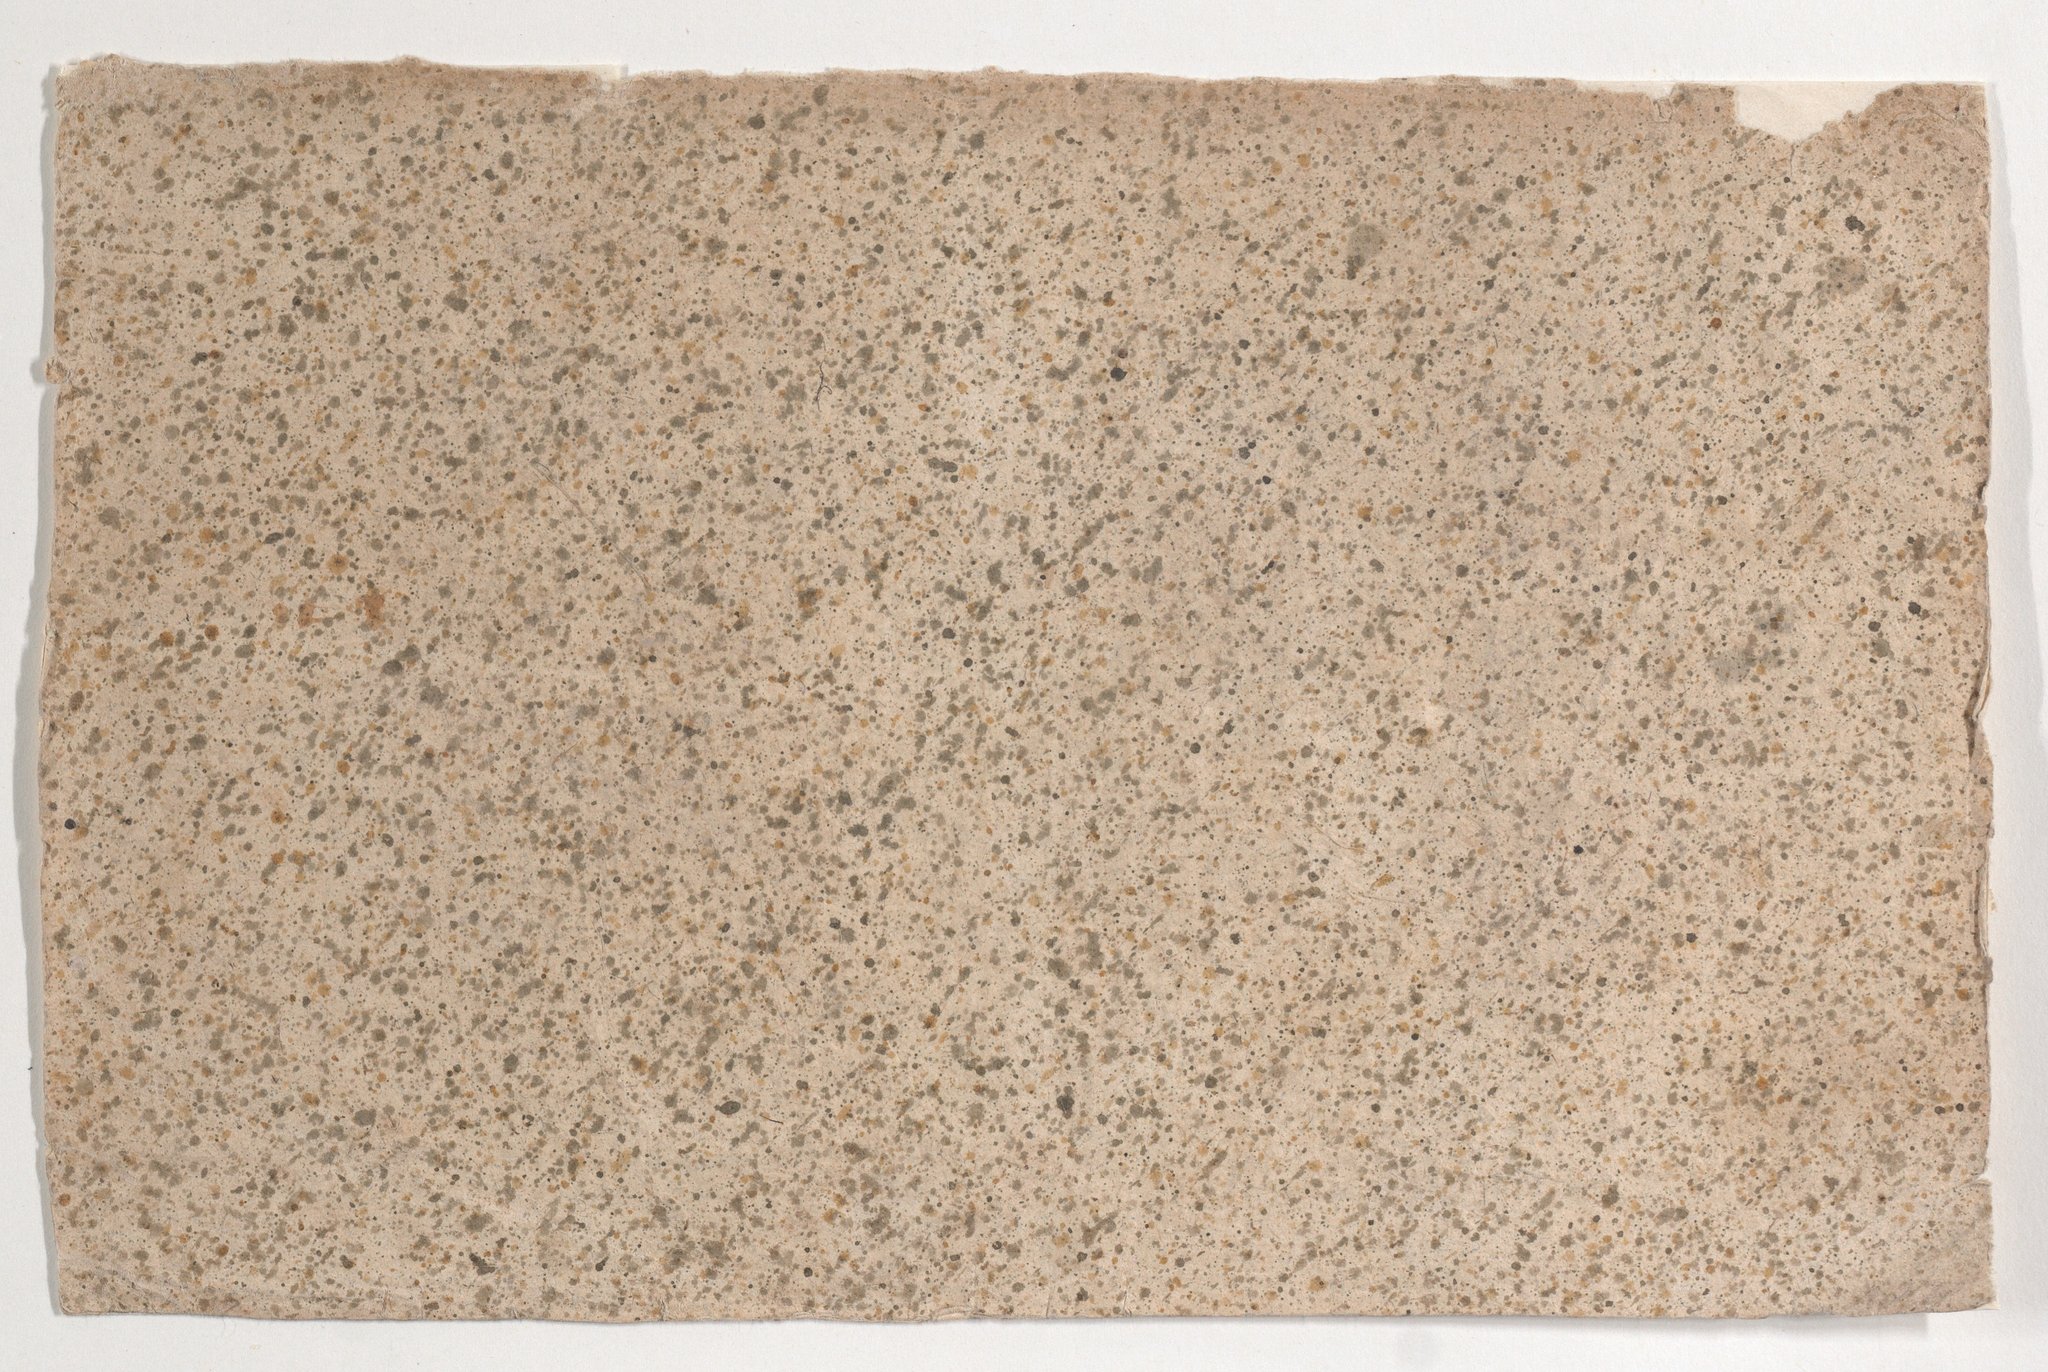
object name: print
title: Sheet with an overall brown speckle pattern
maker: Anonymous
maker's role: artist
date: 1801-1900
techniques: relief print